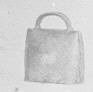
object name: cow bell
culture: european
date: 1801-1900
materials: metal